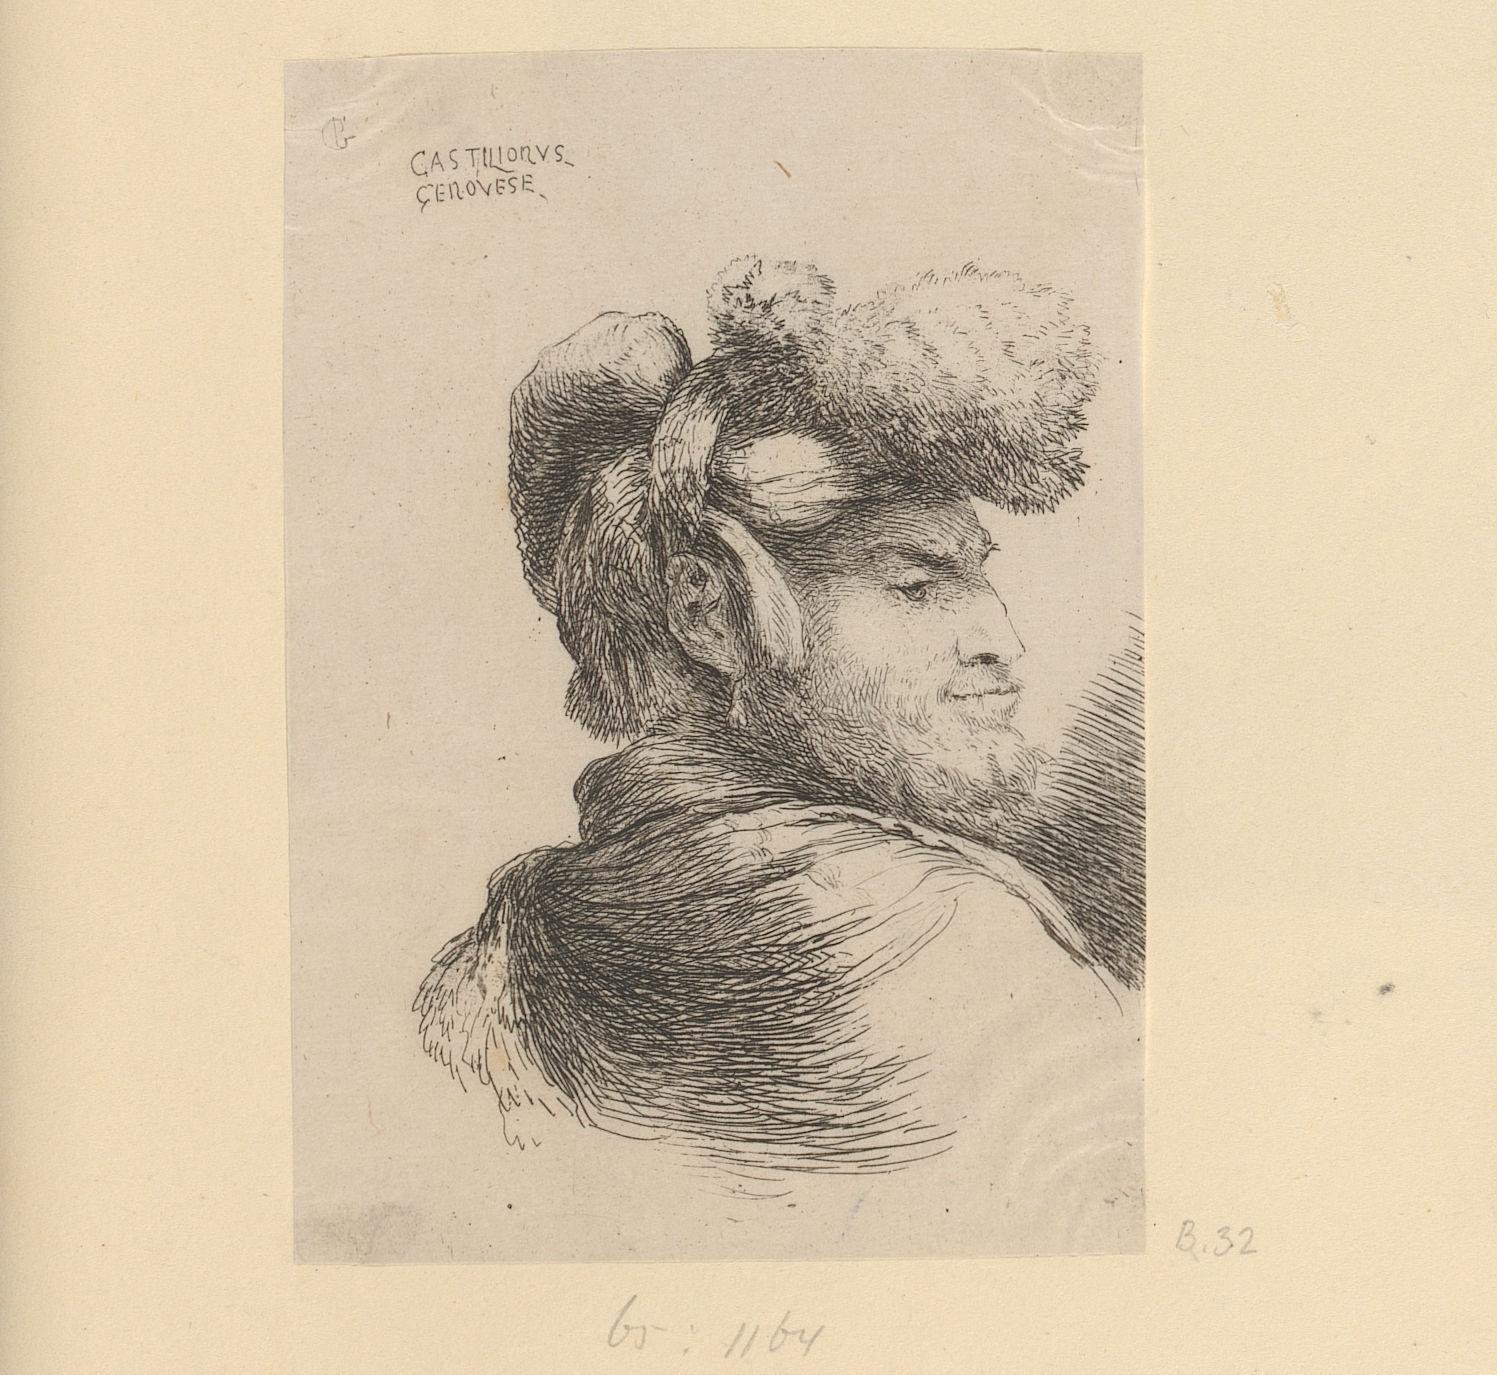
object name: album leaf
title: Kleine studie van hoofden met oosterse hoofddeksels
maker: giovanni benedetto castiglione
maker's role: draughtsman, print maker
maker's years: 1610-1665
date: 1645-1650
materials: paper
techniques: etching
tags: head (human), head-gear: turban (+ men's clothes)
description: Prent is onderdeel van een serie van zestien prenten. Prent maakt mogelijk deel uit van een serie van 200 prenten. Deze serie is onder de titel 'A Collection of two hundred original etchings' voor het eerst uitgegeven door J.M. Greery in 1816.